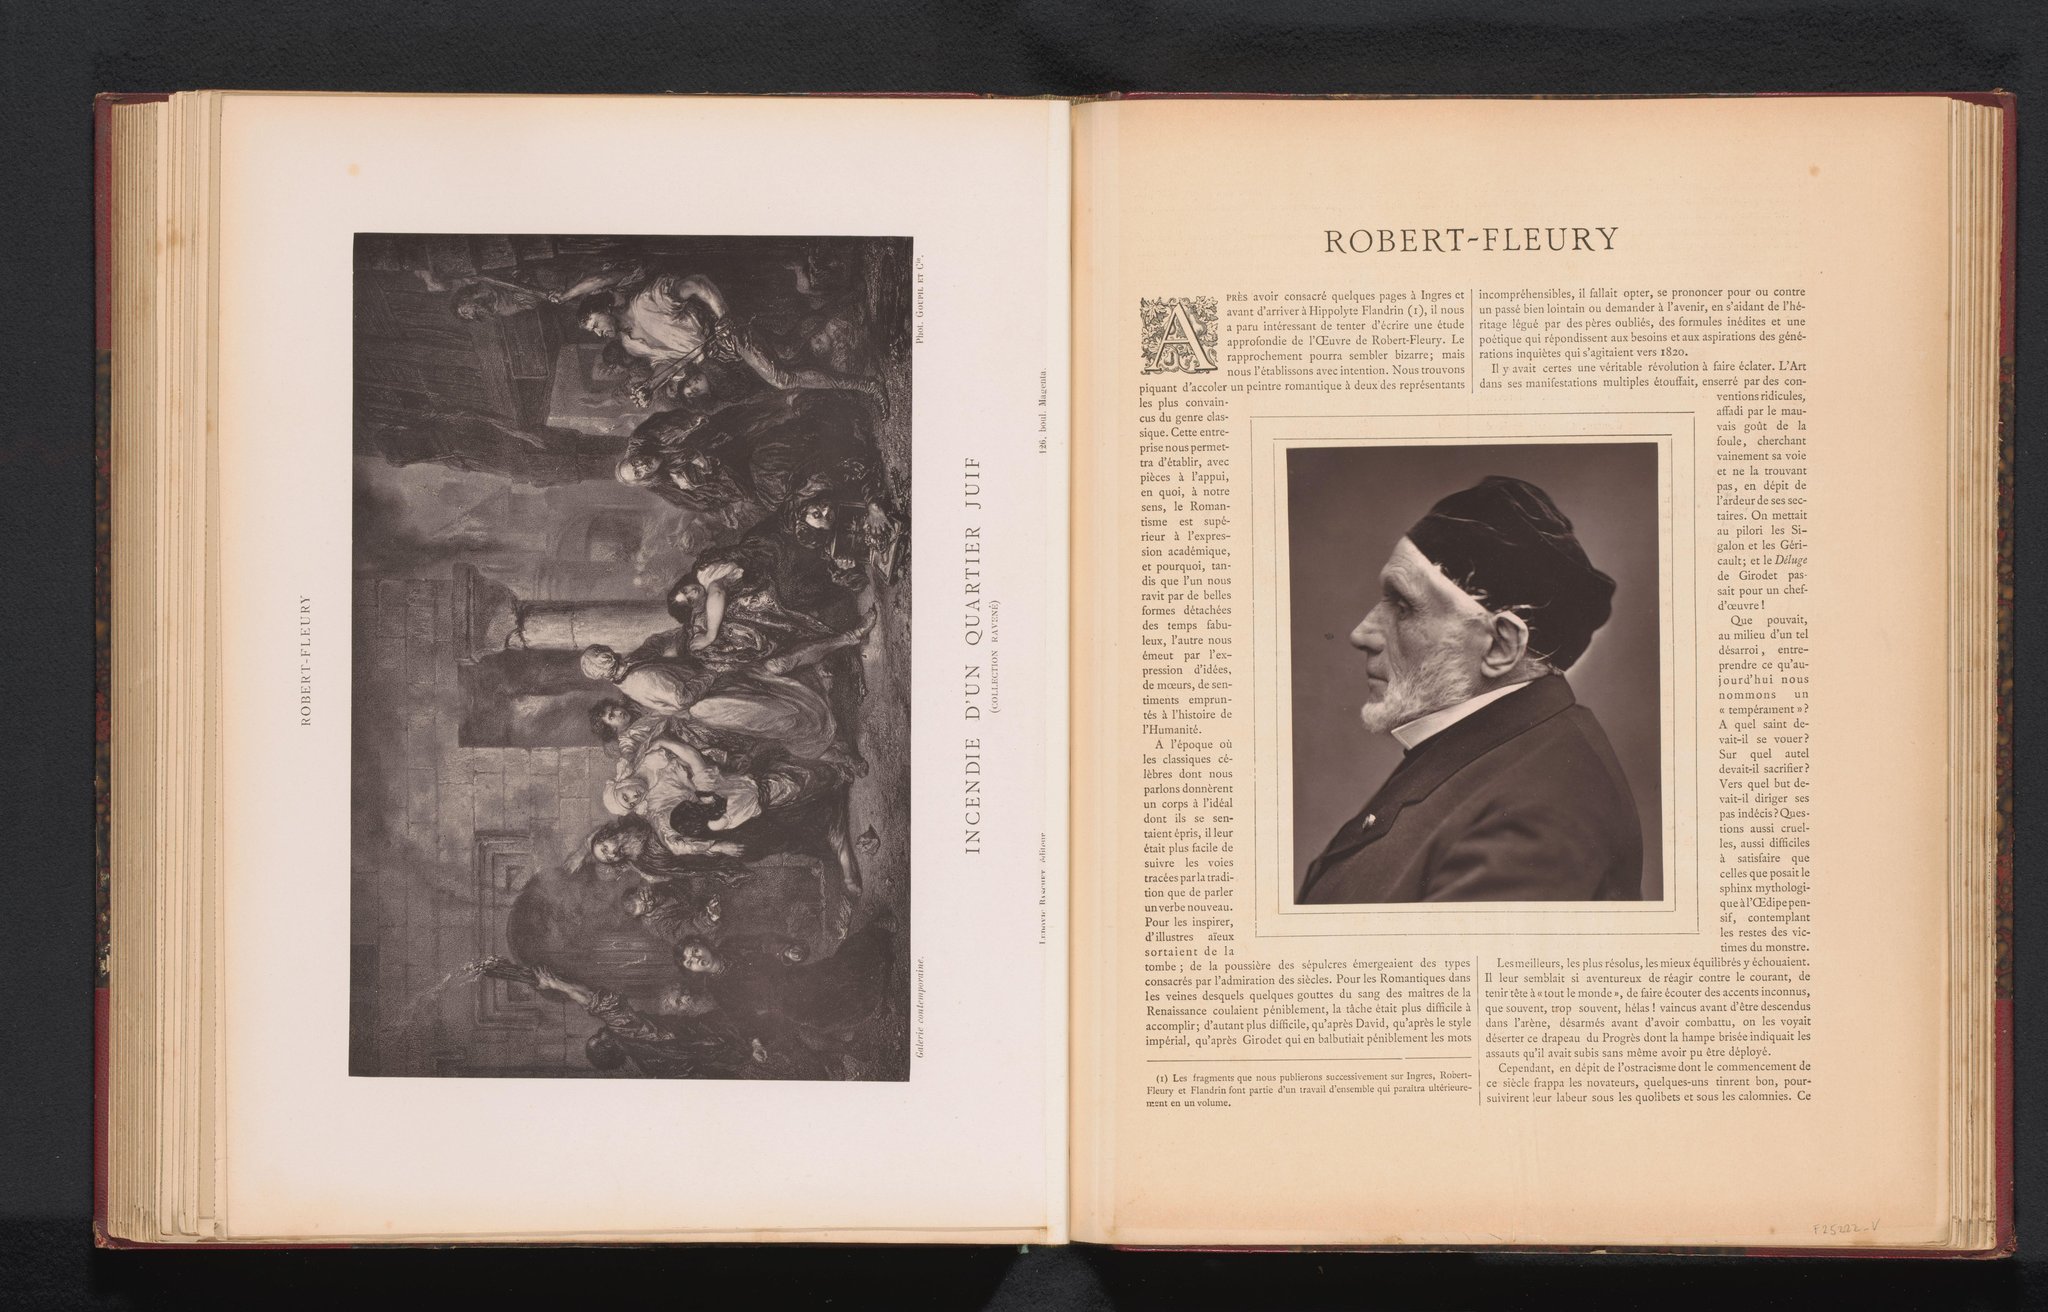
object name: photomechanical print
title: Portret van Joseph-Nicolas Robert-Fleury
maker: Anonymous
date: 1874-1879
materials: paper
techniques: woodburytype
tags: painter, draughtsman, joseph nicolas robert-fleury, adult man, historical persons